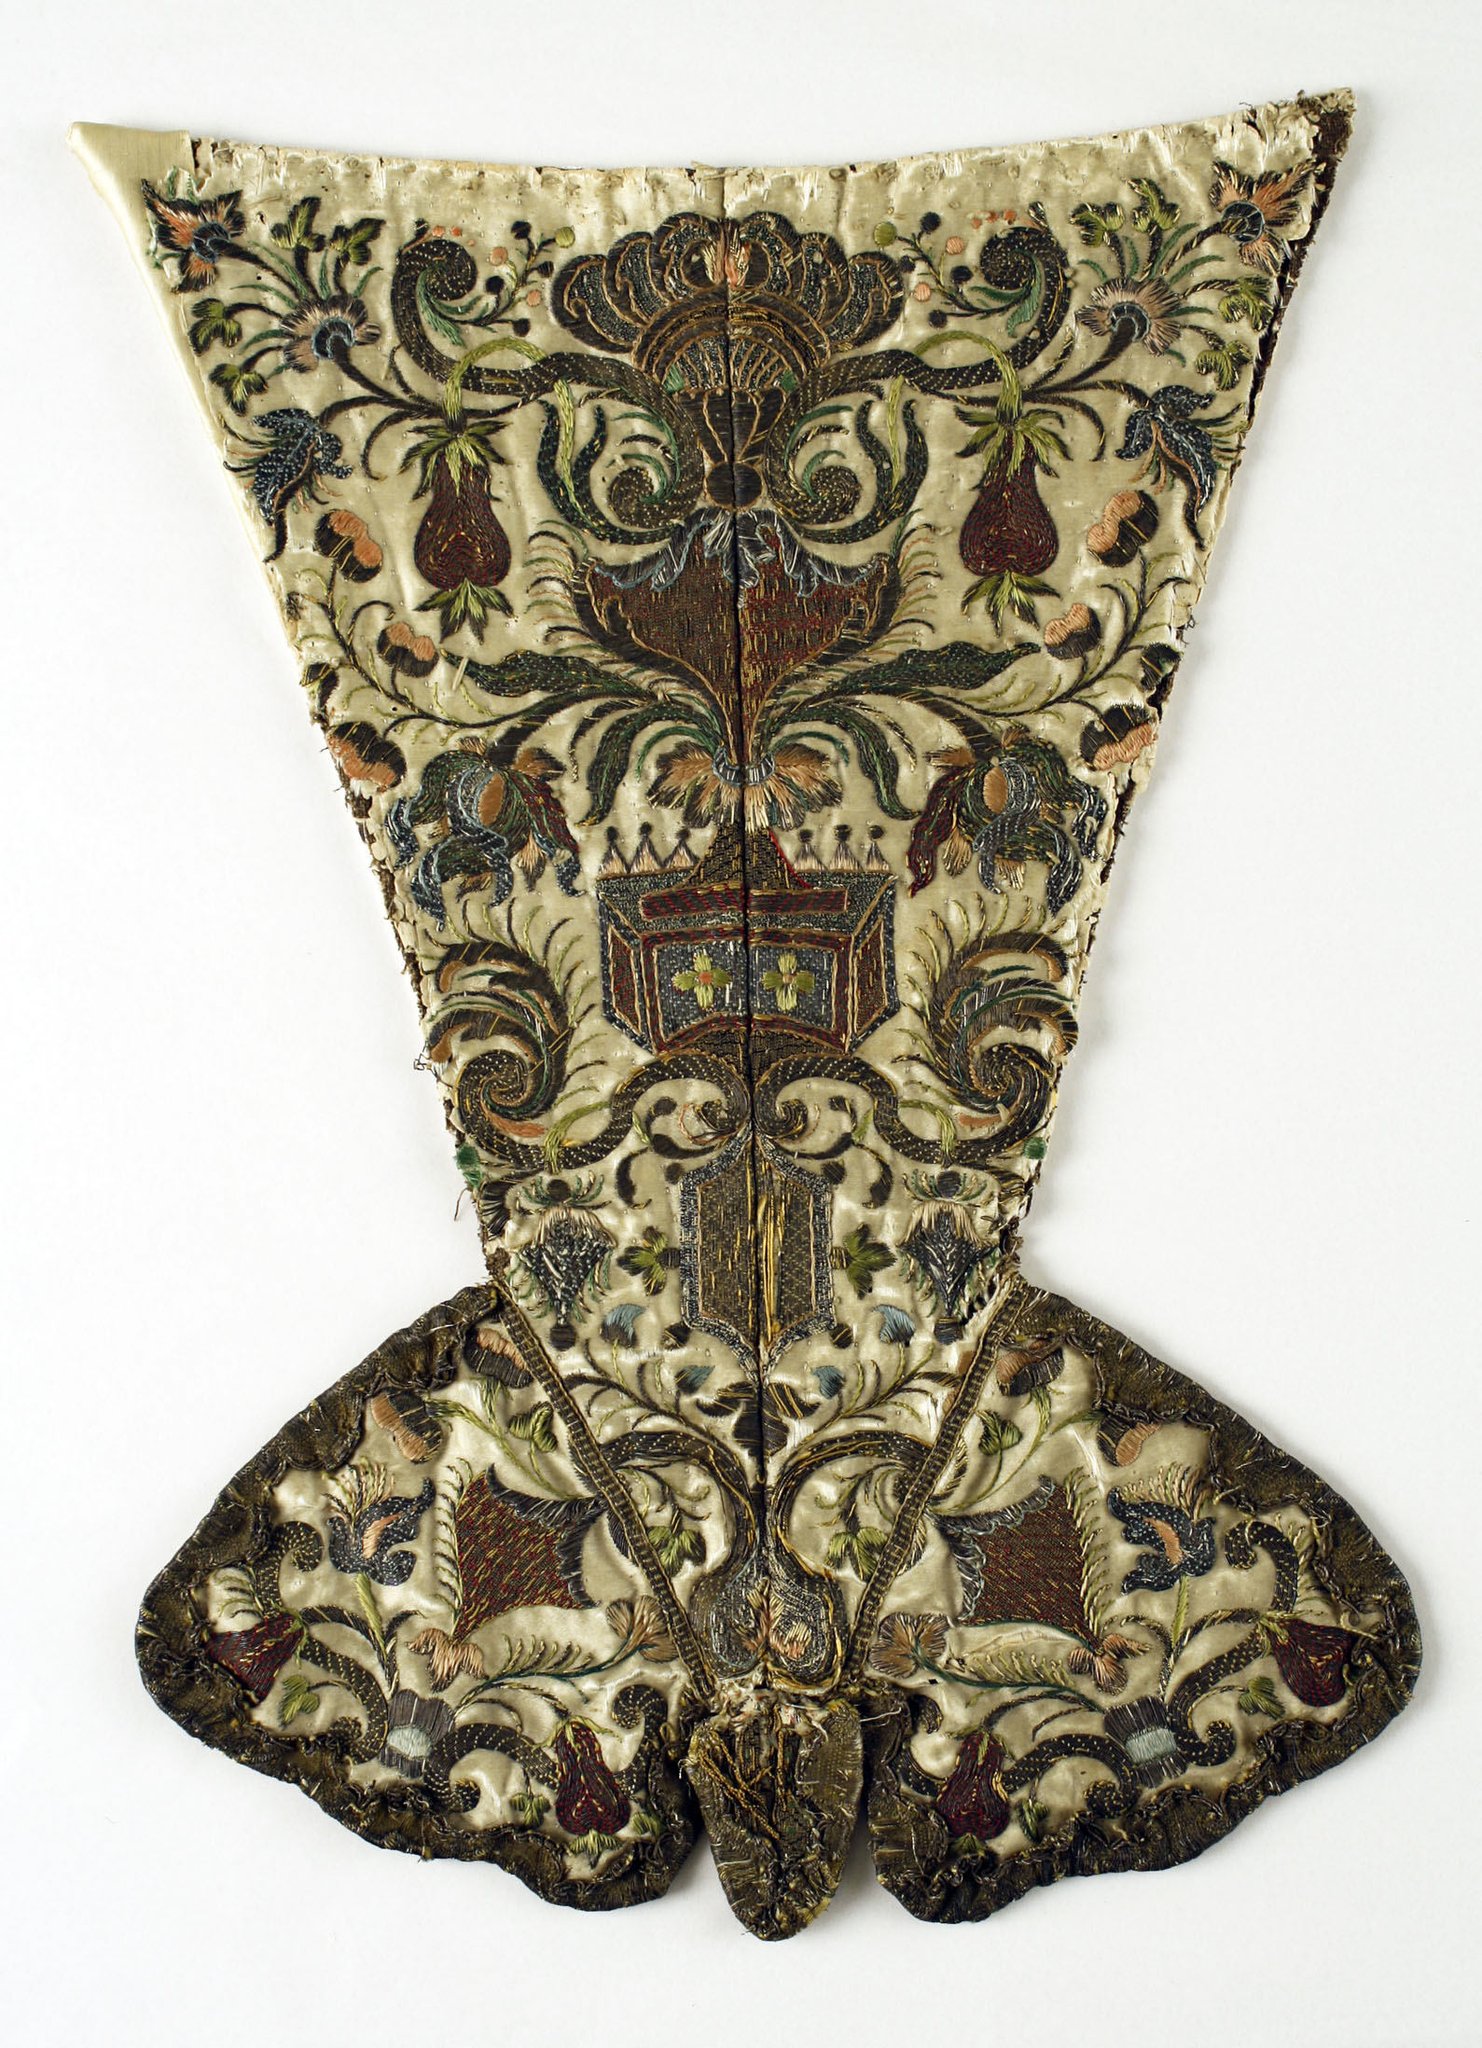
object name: stomacher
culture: italian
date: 1701-1733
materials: silk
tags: fruit